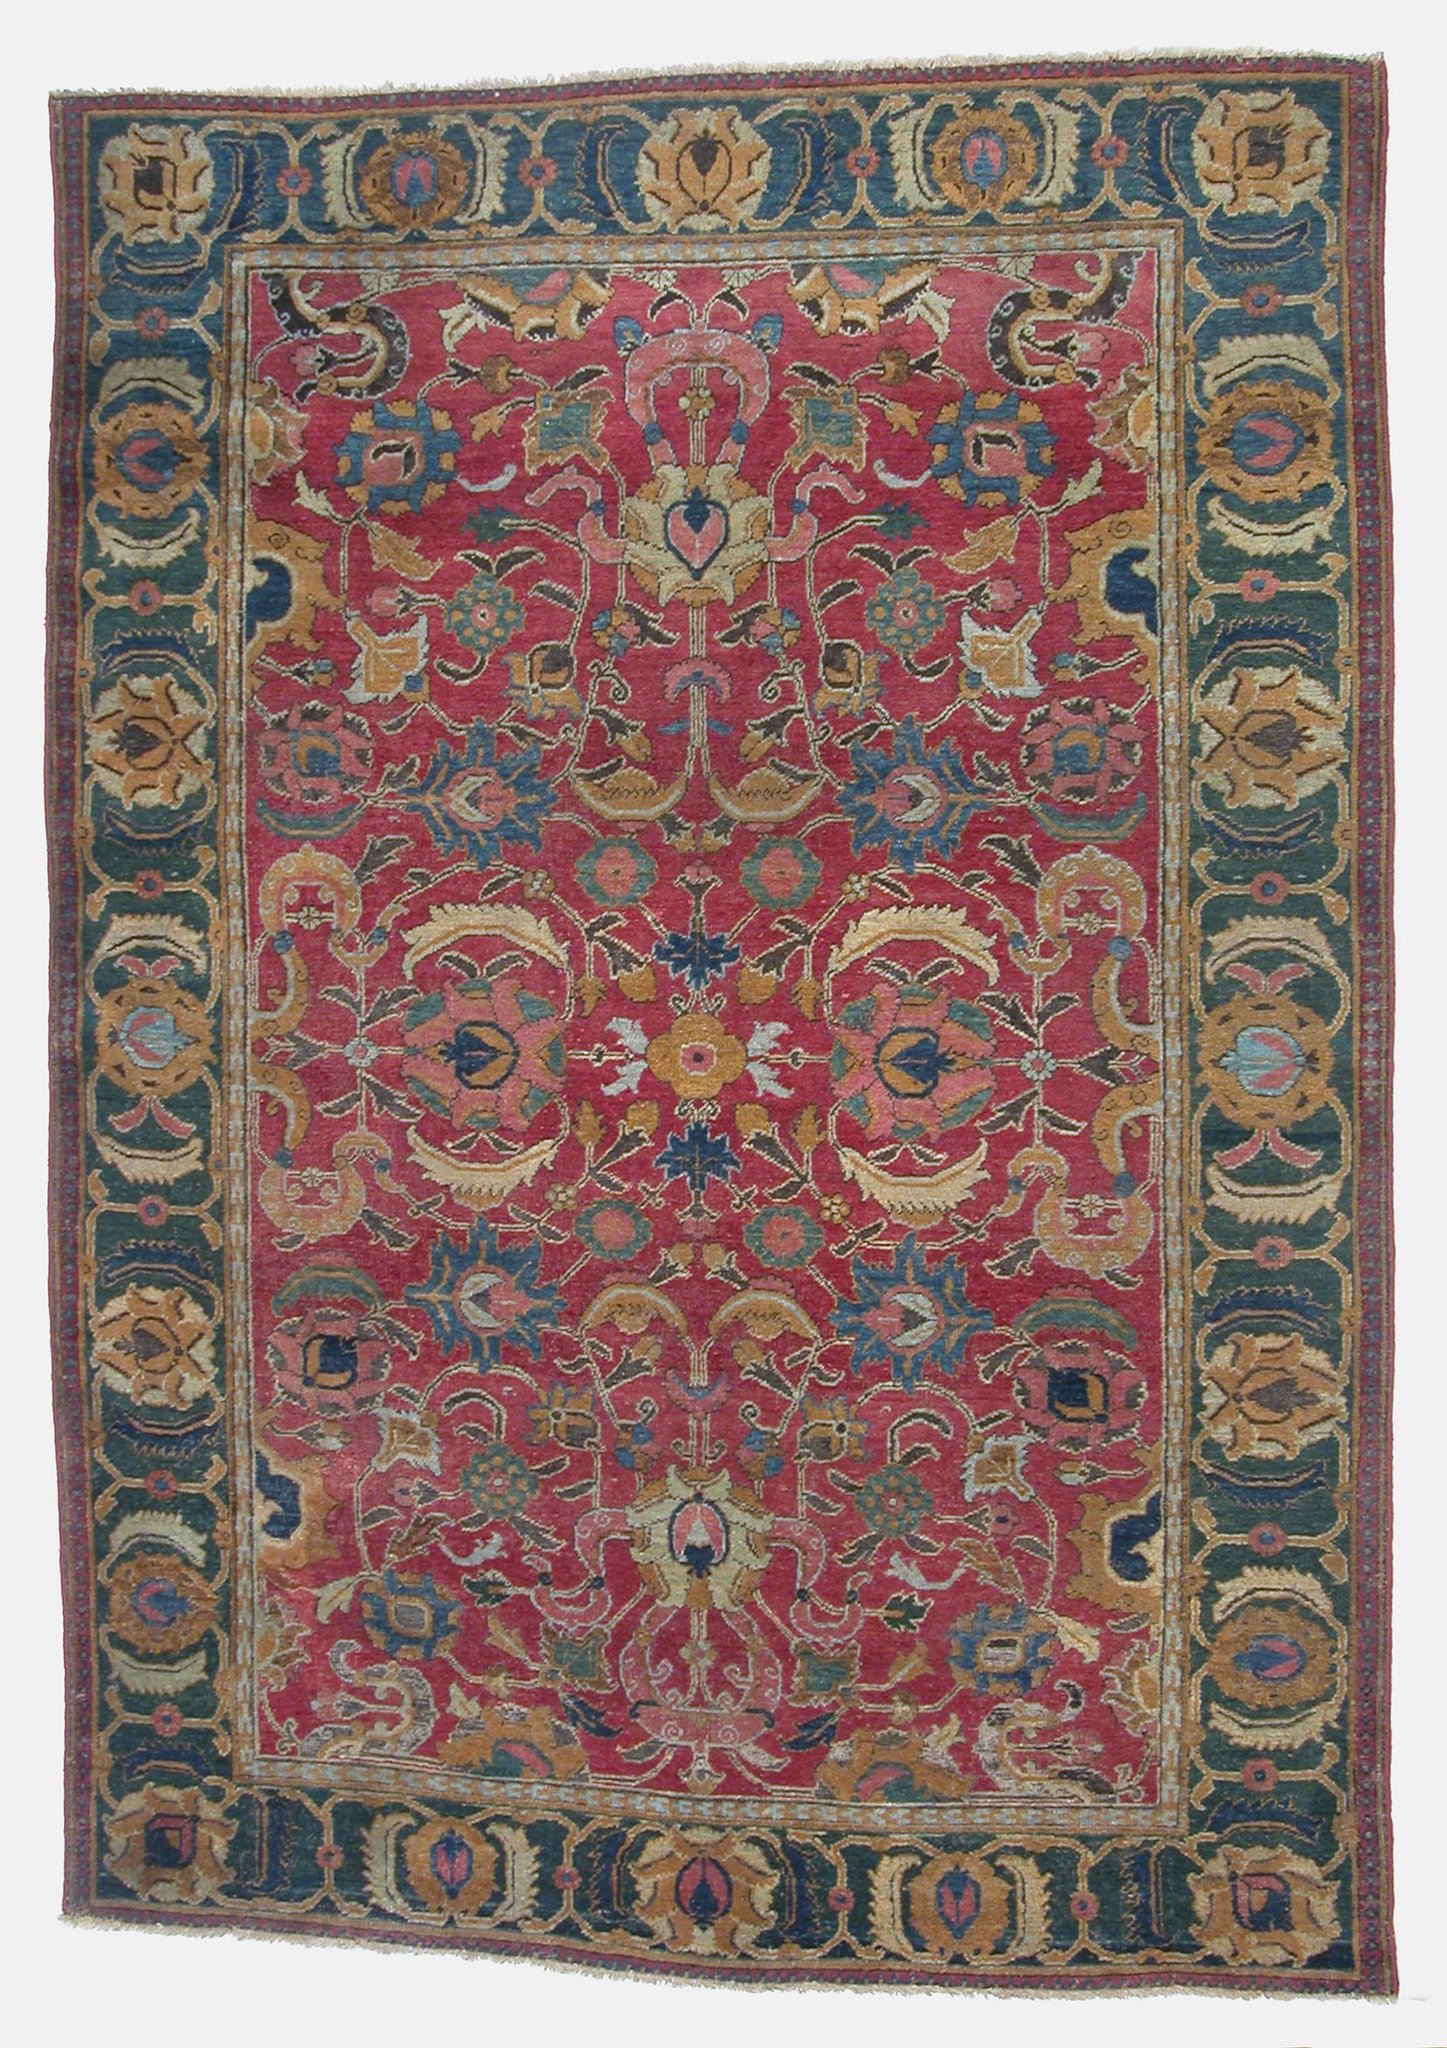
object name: carpet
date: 1601-1700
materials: cotton, wool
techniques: asymmetrically knotted pile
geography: iran